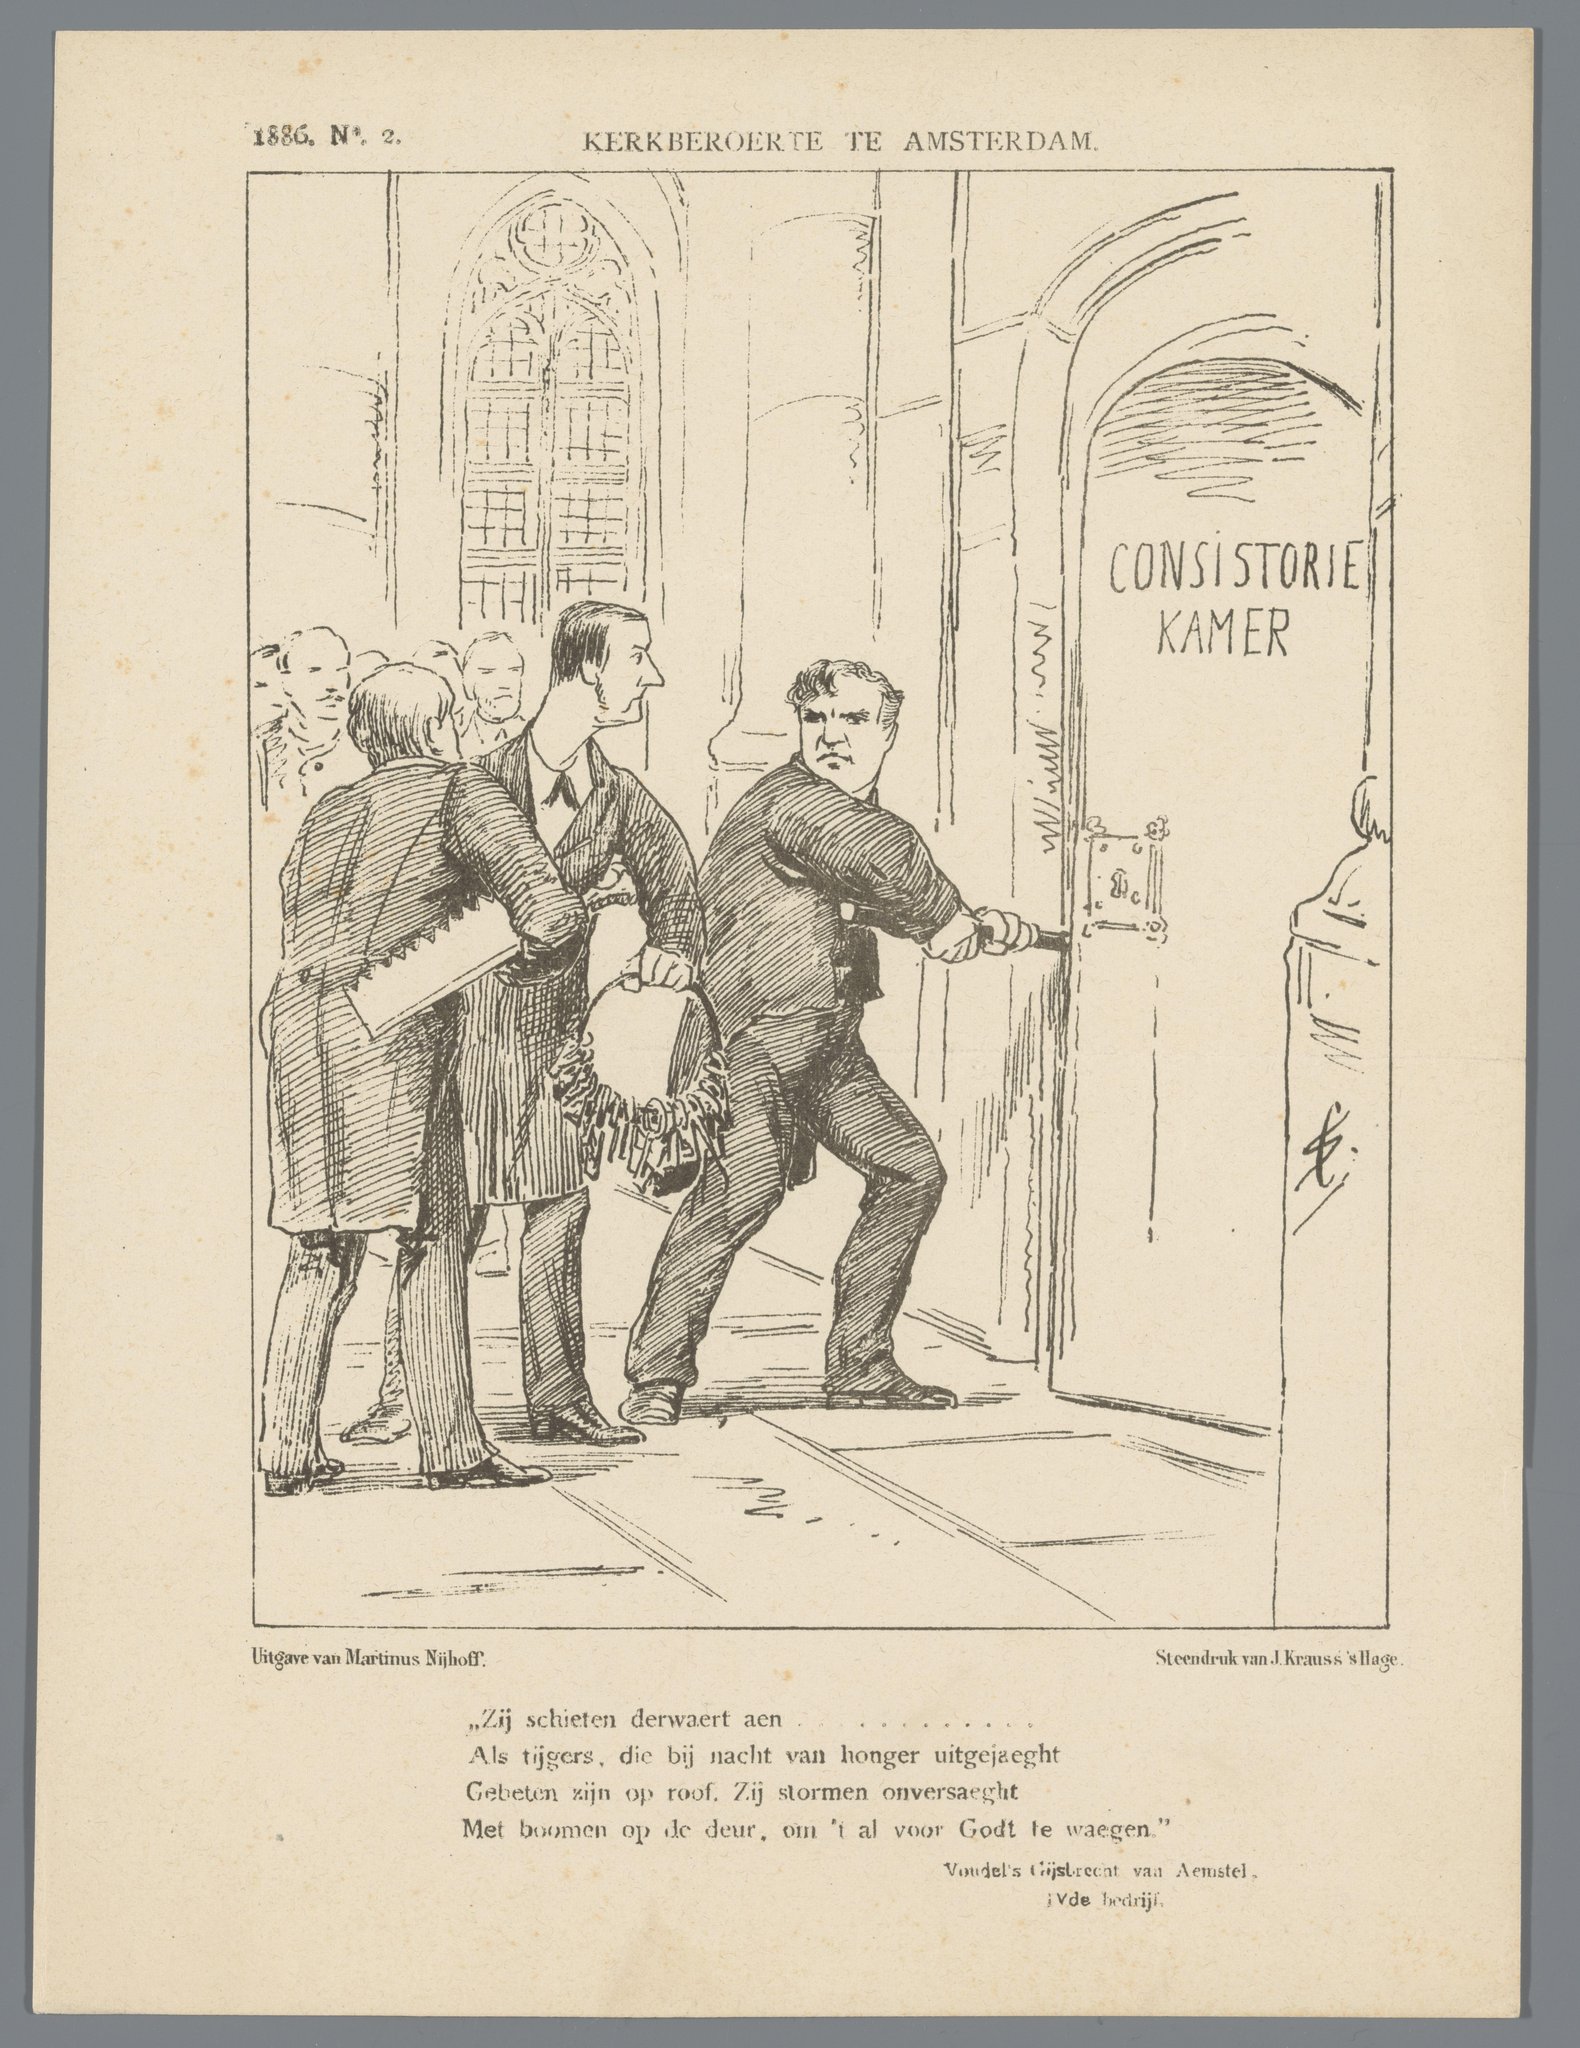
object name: print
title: Kerkberoerte te Amsterdam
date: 1886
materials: paper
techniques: lithograph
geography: the hague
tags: the hague, abraham kuyper, amsterdam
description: Spotprent met Abraham Kuyper die de deur van de consistorie van een kerk te Amsterdam openbreekt. Plaat verschenen bij het weekblad De Nederlandsche Spectator, nr. 2, 1886.